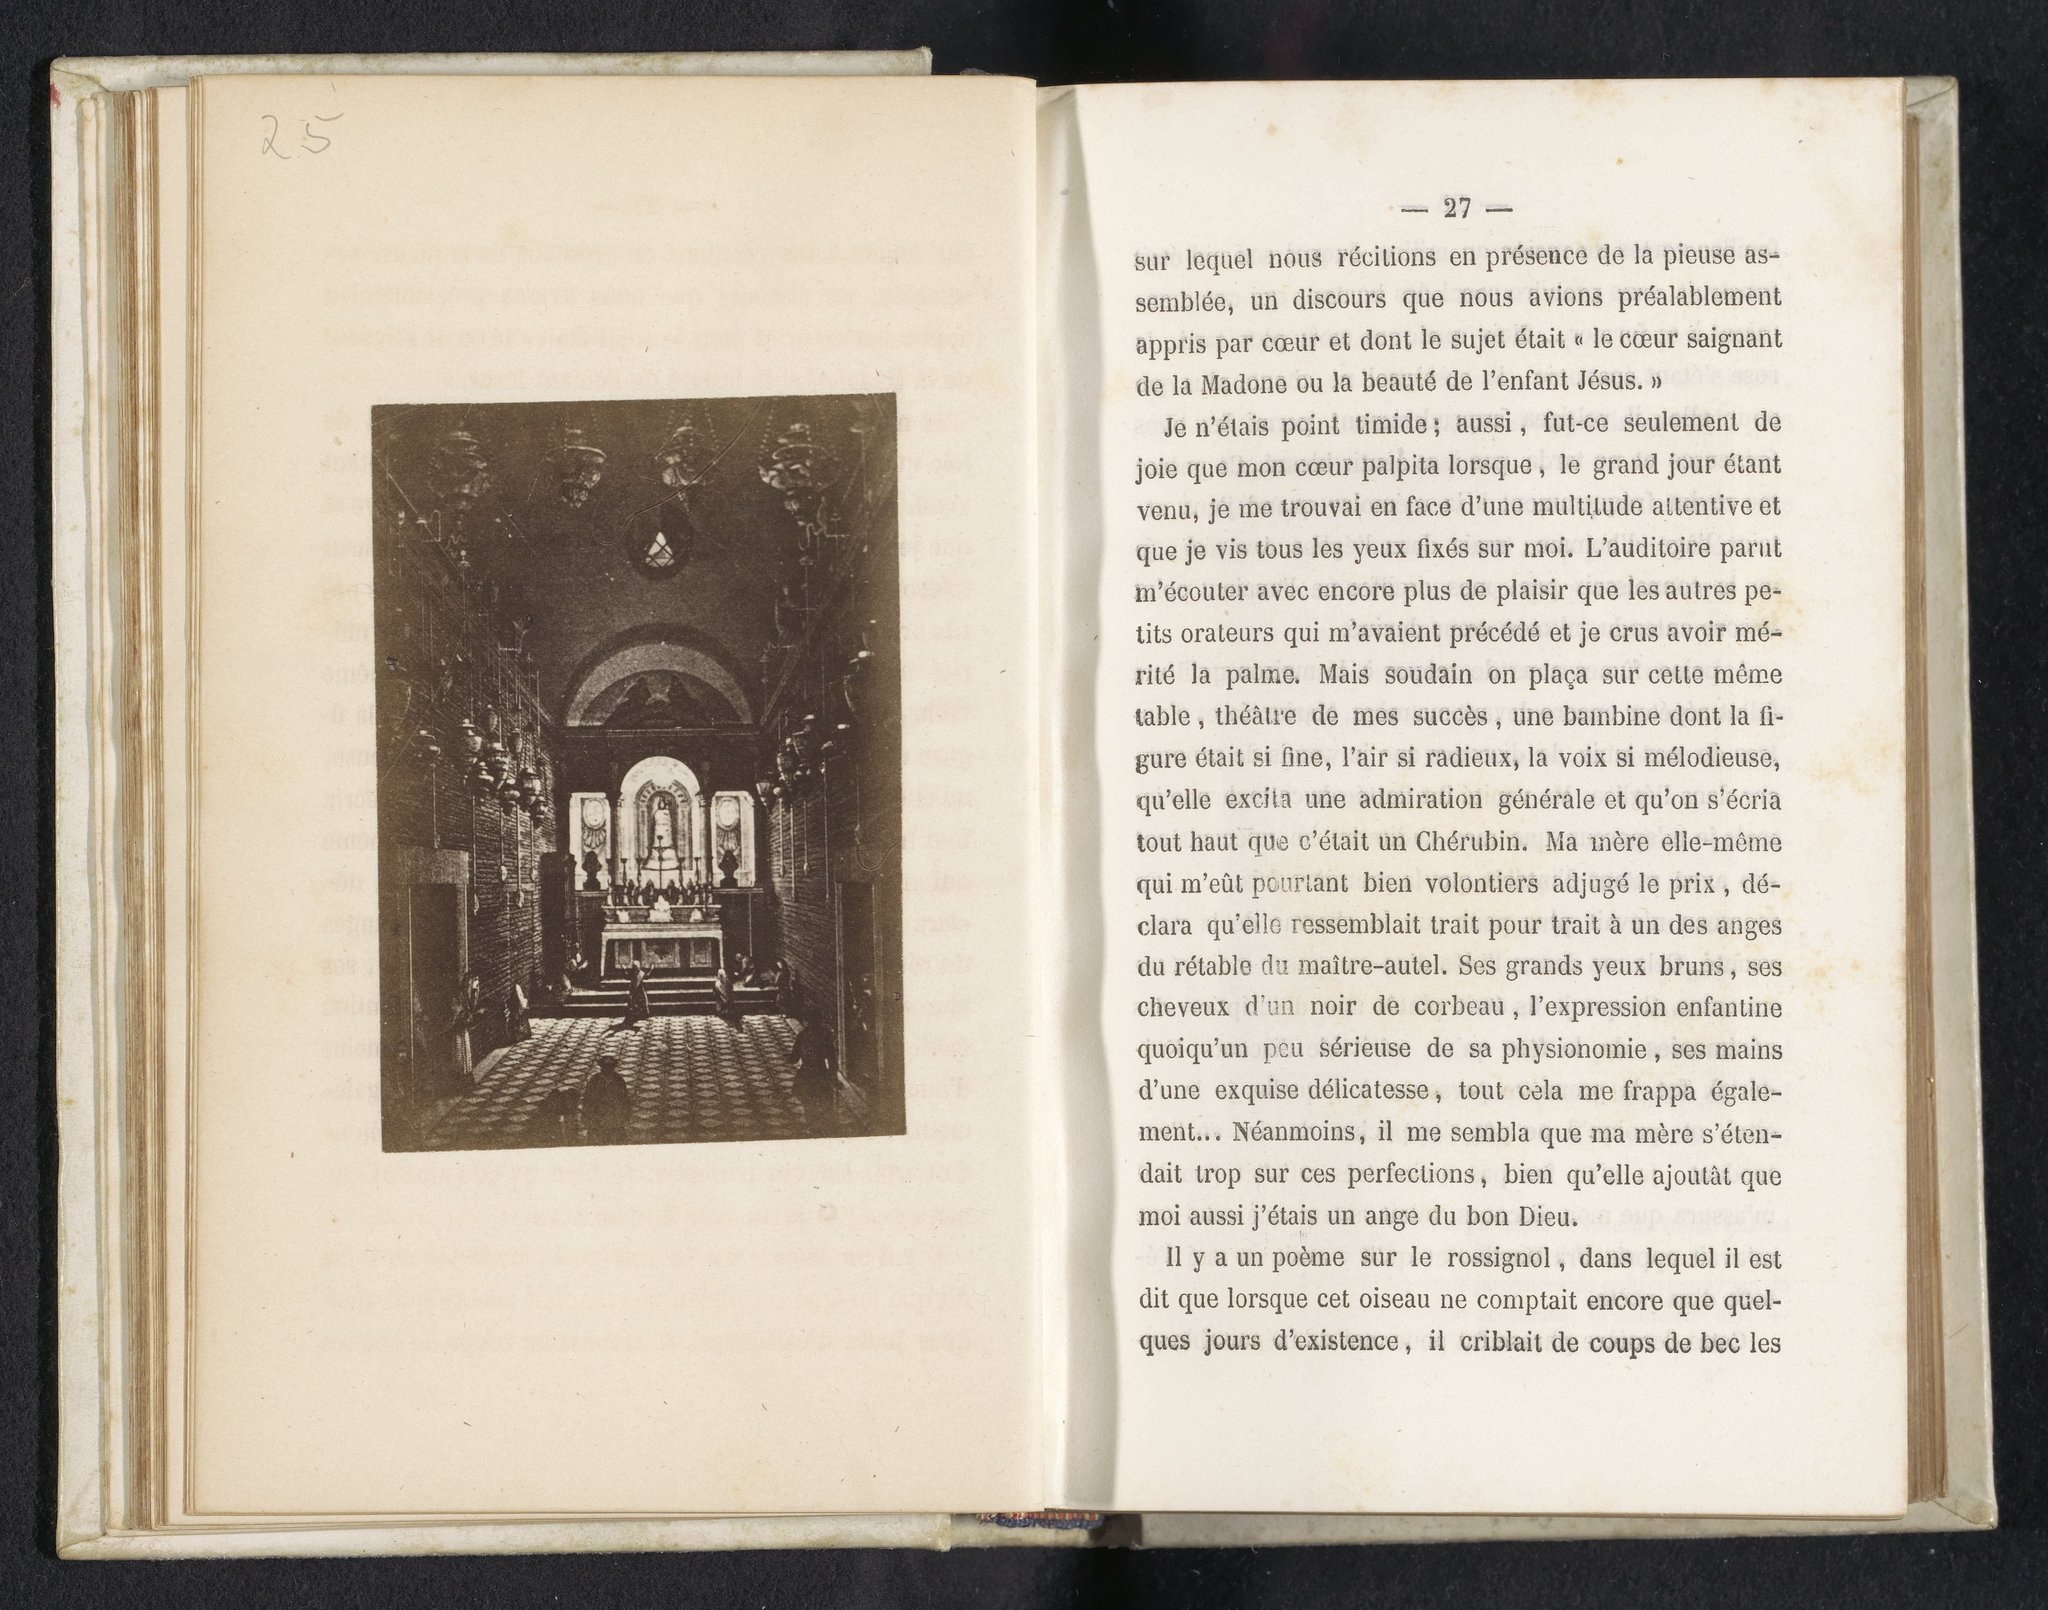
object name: page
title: Fotoreproductie van een schilderij, voorstellende een interieur van een kerk (vermoedelijk) te Rome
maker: Anonymous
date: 1850-1860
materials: photographic support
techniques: albumen print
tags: interior of church